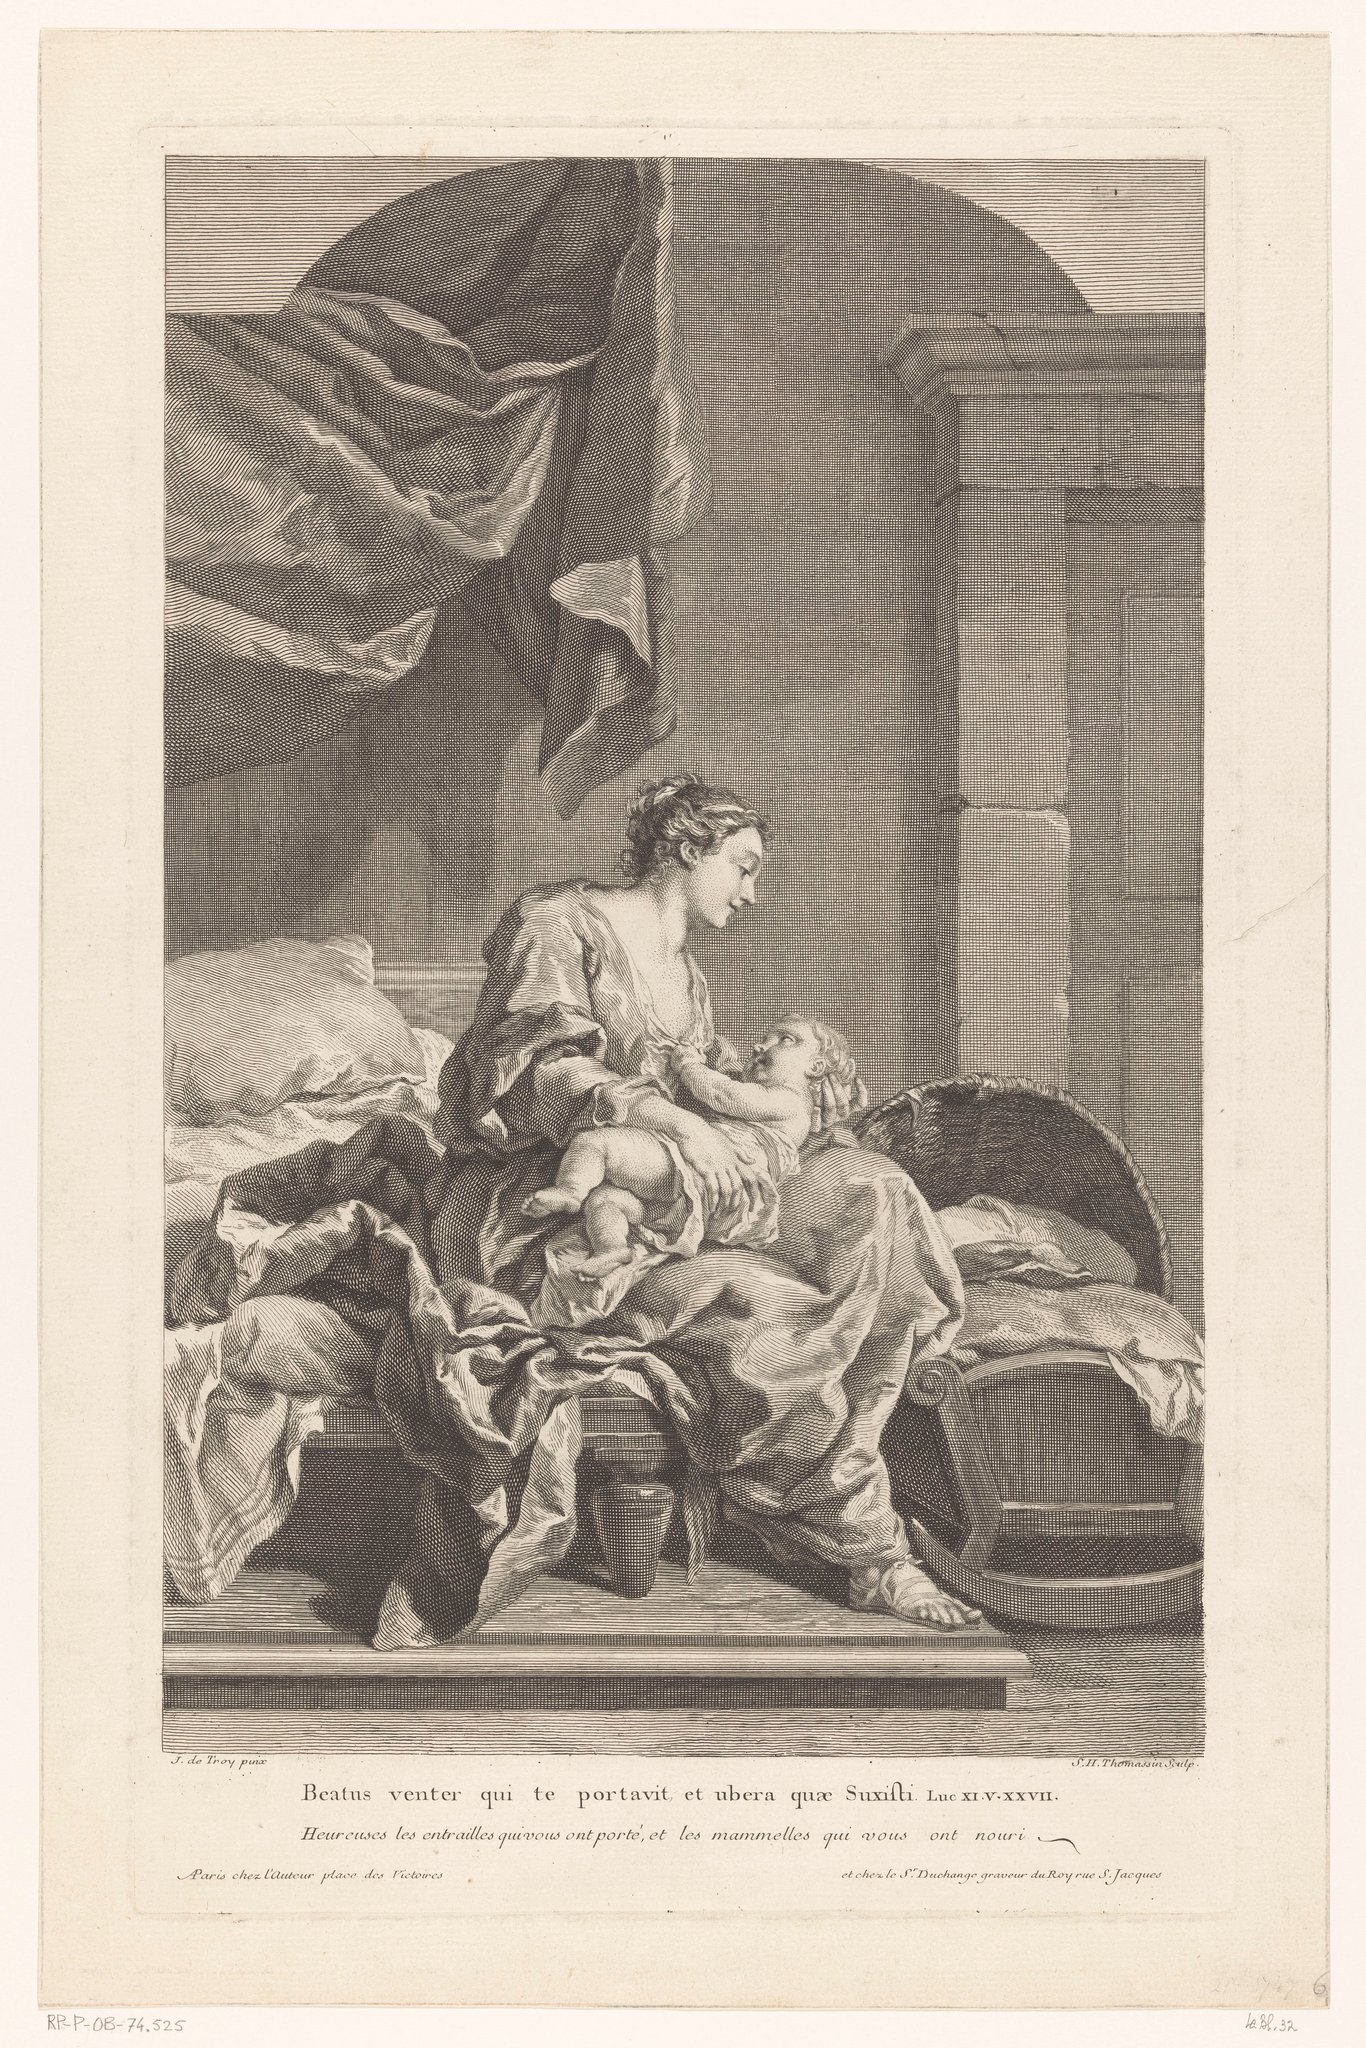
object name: print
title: Maria geeft het Christuskind de borst (Maria lactans)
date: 1697-1741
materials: paper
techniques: engraving, etching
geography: paris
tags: bed, cradle, crib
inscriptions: collector's mark: Lugt 240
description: Interieur met Maria zittend op een bed, de borst gevend aan het Christuskind; aan het voeteneinde van het bed een wieg.